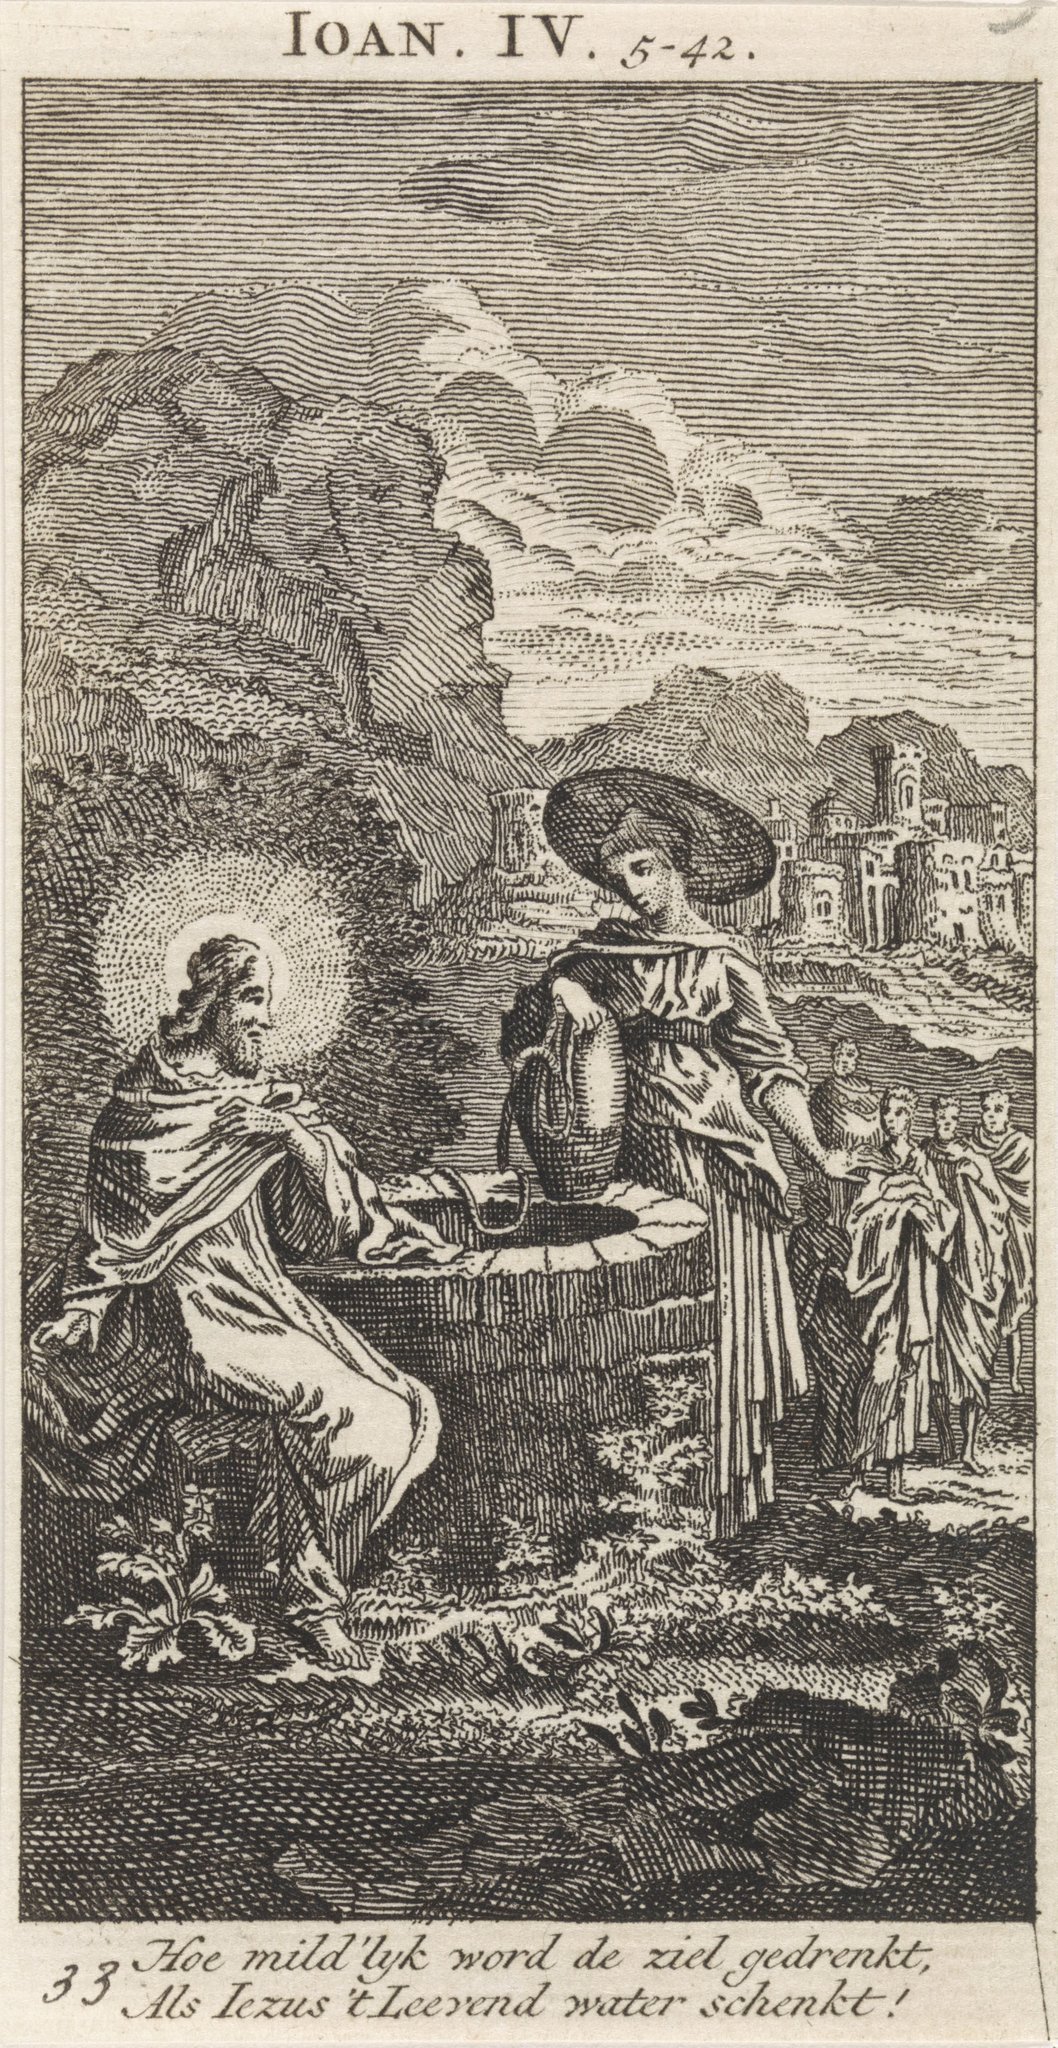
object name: print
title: Christus en de Samaritaanse vrouw bij de put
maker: Anonymous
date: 1712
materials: paper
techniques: etching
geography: amsterdam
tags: well, christ and the woman of samaria: sitting at jacob's well he asks her for a drink from her jug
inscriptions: collector's mark: Lugt 2228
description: Kopie van illustratie voor: Luyken, Jan. Bybel printen. Amsterdam: Pieter Arentsz. II (wed.) en Cornelis van der Sys, 1712, p. 32.